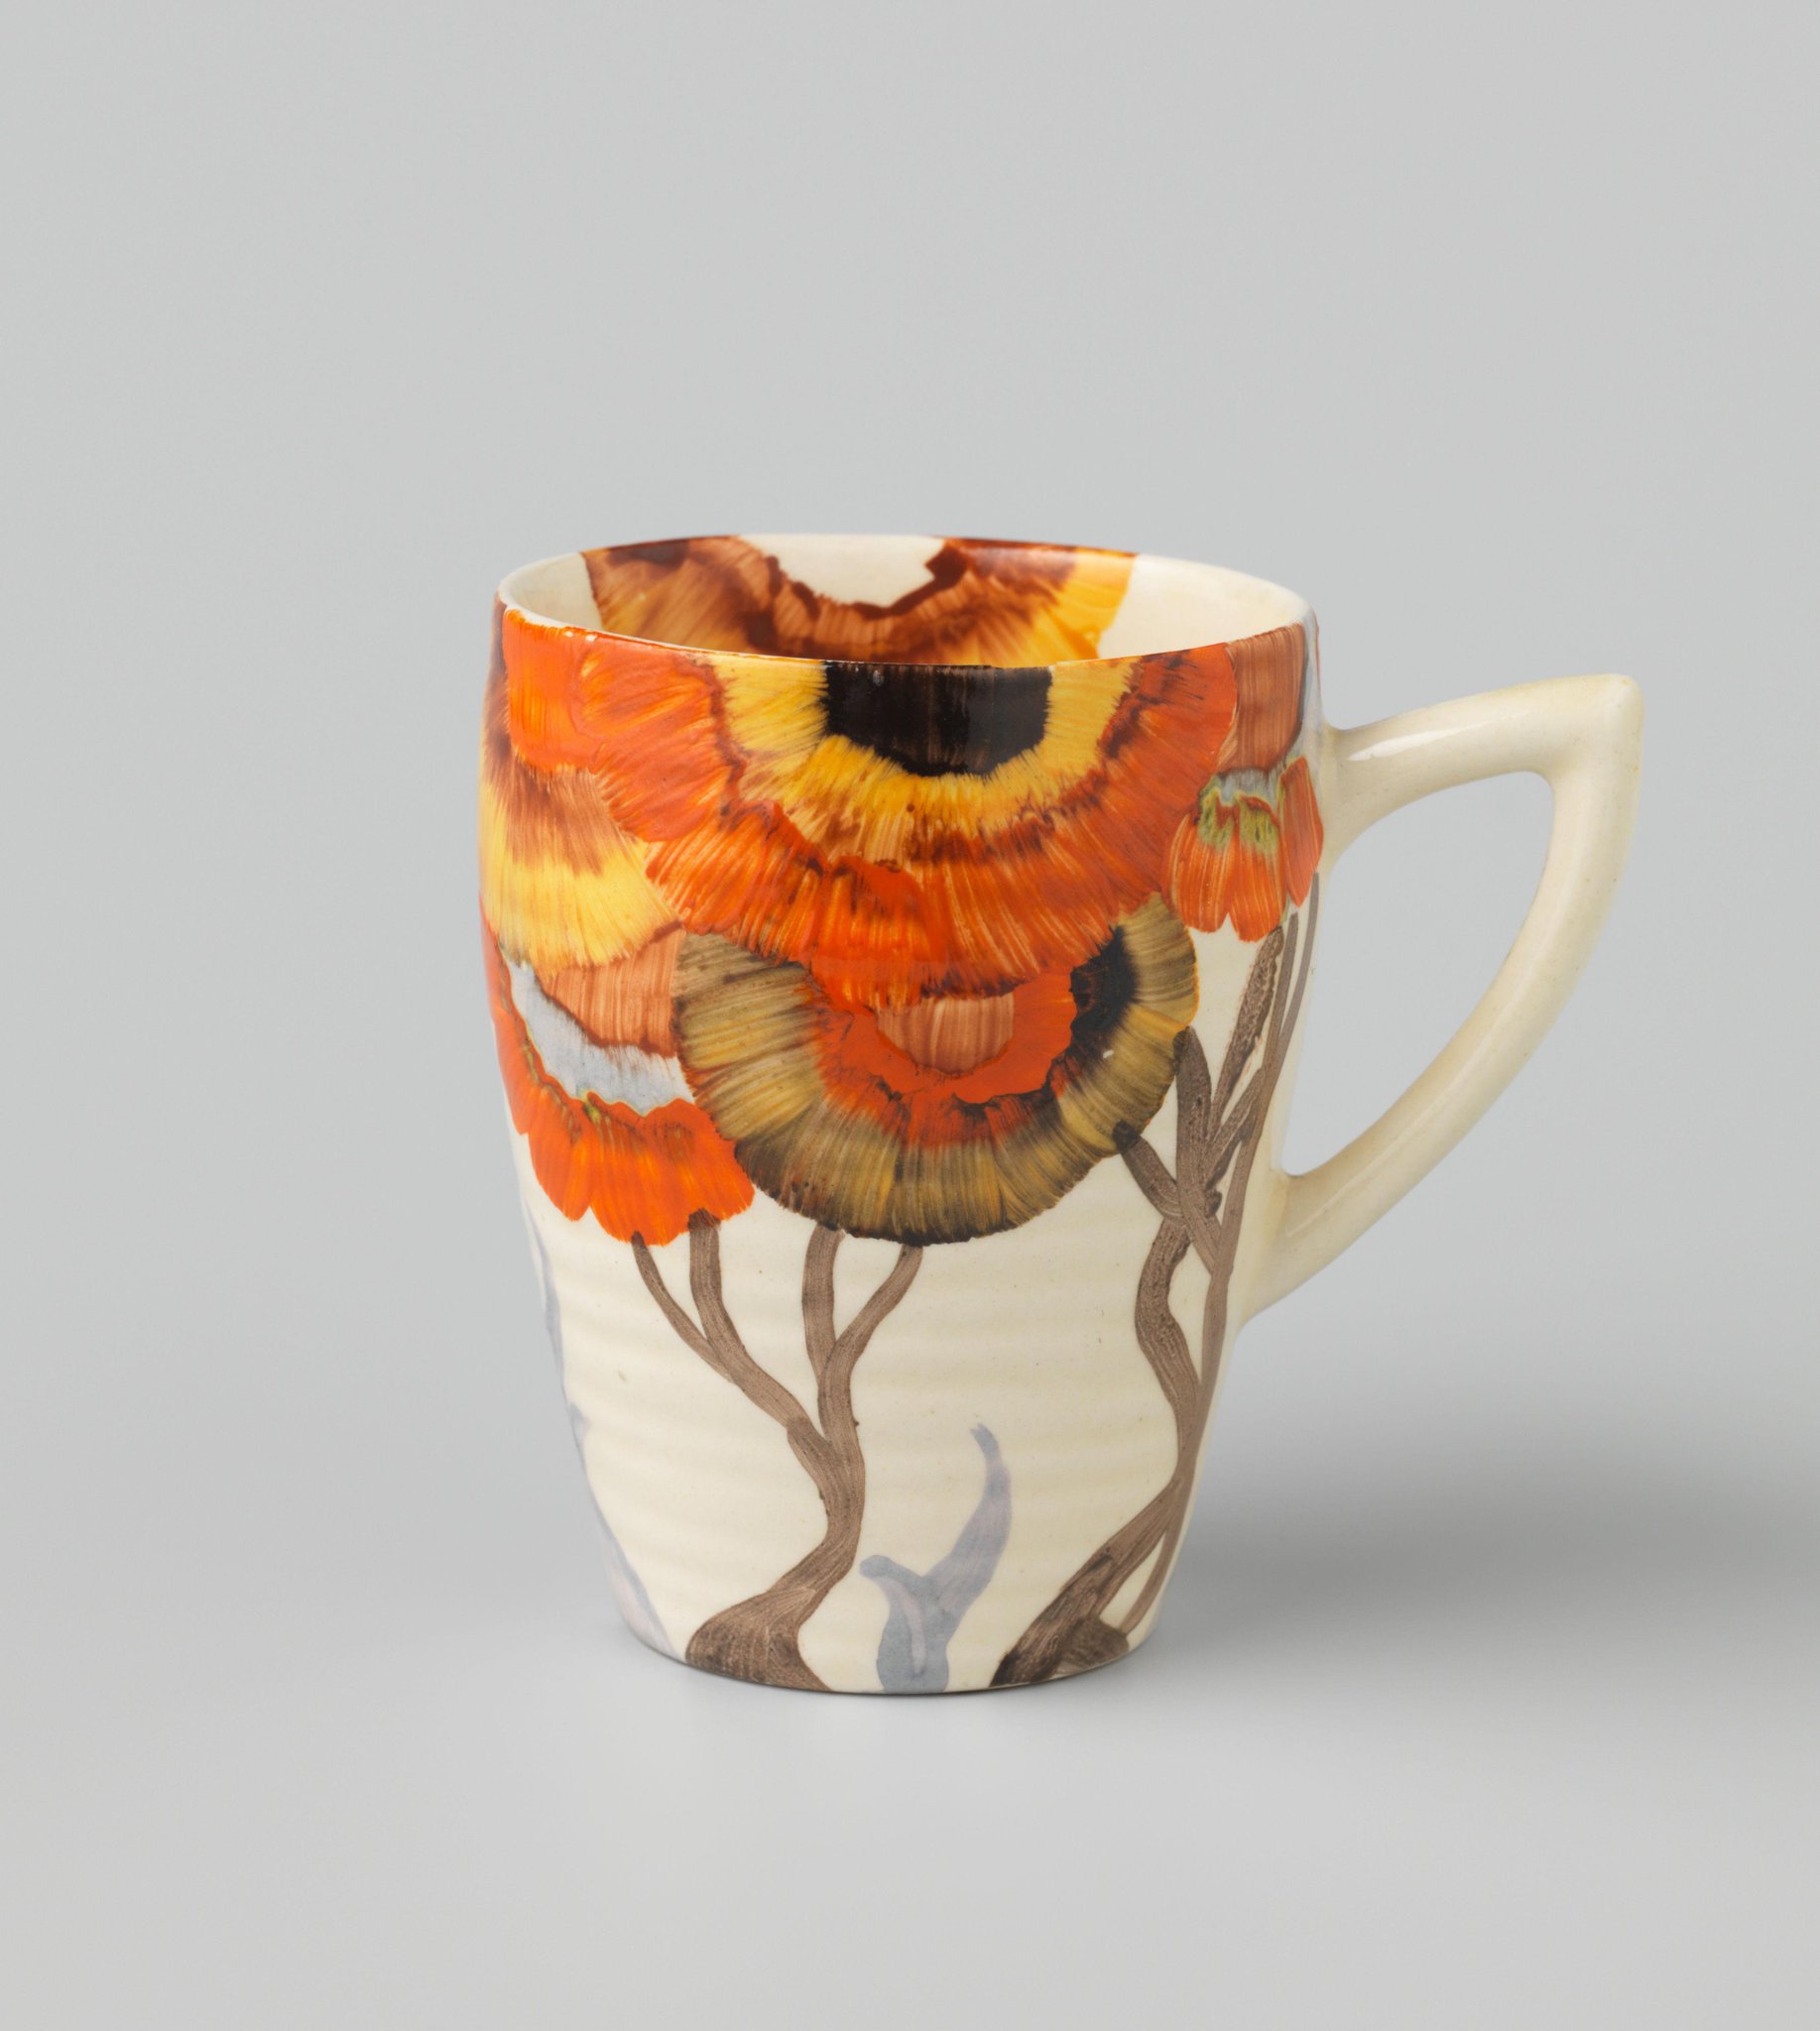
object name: tea cup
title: Theekop met veelkleurig bloemendecor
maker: clarice cliff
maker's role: ceramicist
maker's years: 1899-1972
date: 1930-1940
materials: earthenware, chemical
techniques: painted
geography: england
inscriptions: mark: ‘HAND PAINTED, BIZARRE by CLARICE CLIFF, WILKINSON Ltd, ENGLAND, gestempeld in zwart’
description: Theekop van aardewerk, veelkleurig beschilderd met bloemendecor. Onderdeel van theeservies.